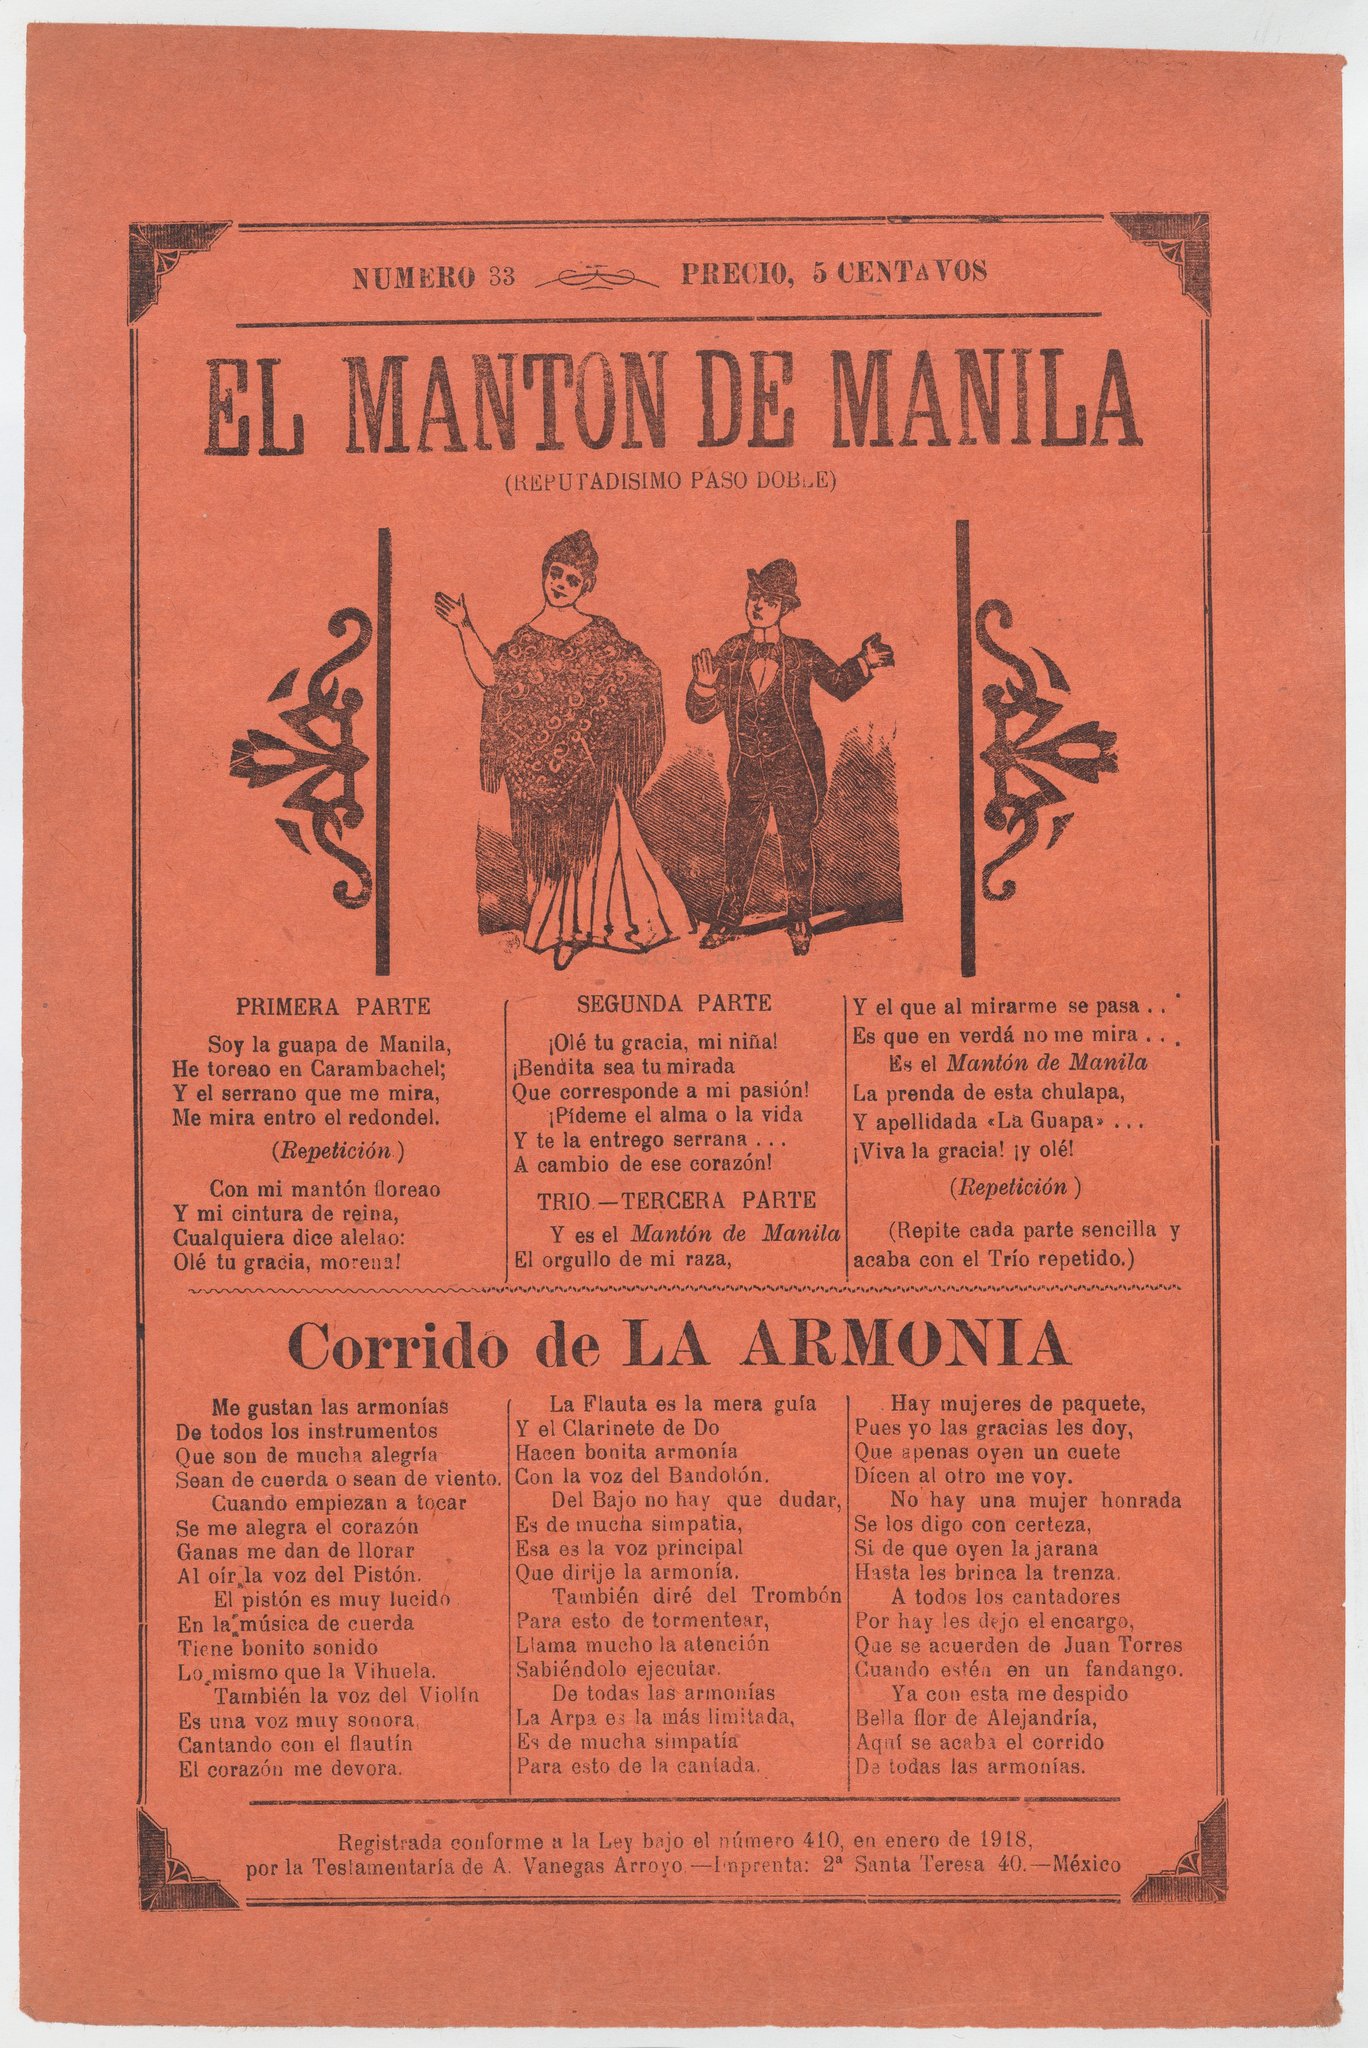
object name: print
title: Broadsheet with songs for a two-step dance, a couple dancing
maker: josé guadalupe posada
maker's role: artist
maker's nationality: mexican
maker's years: 1852-1913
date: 1918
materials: metal, paper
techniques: engraving, letterpress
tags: couples,men,women,dancing